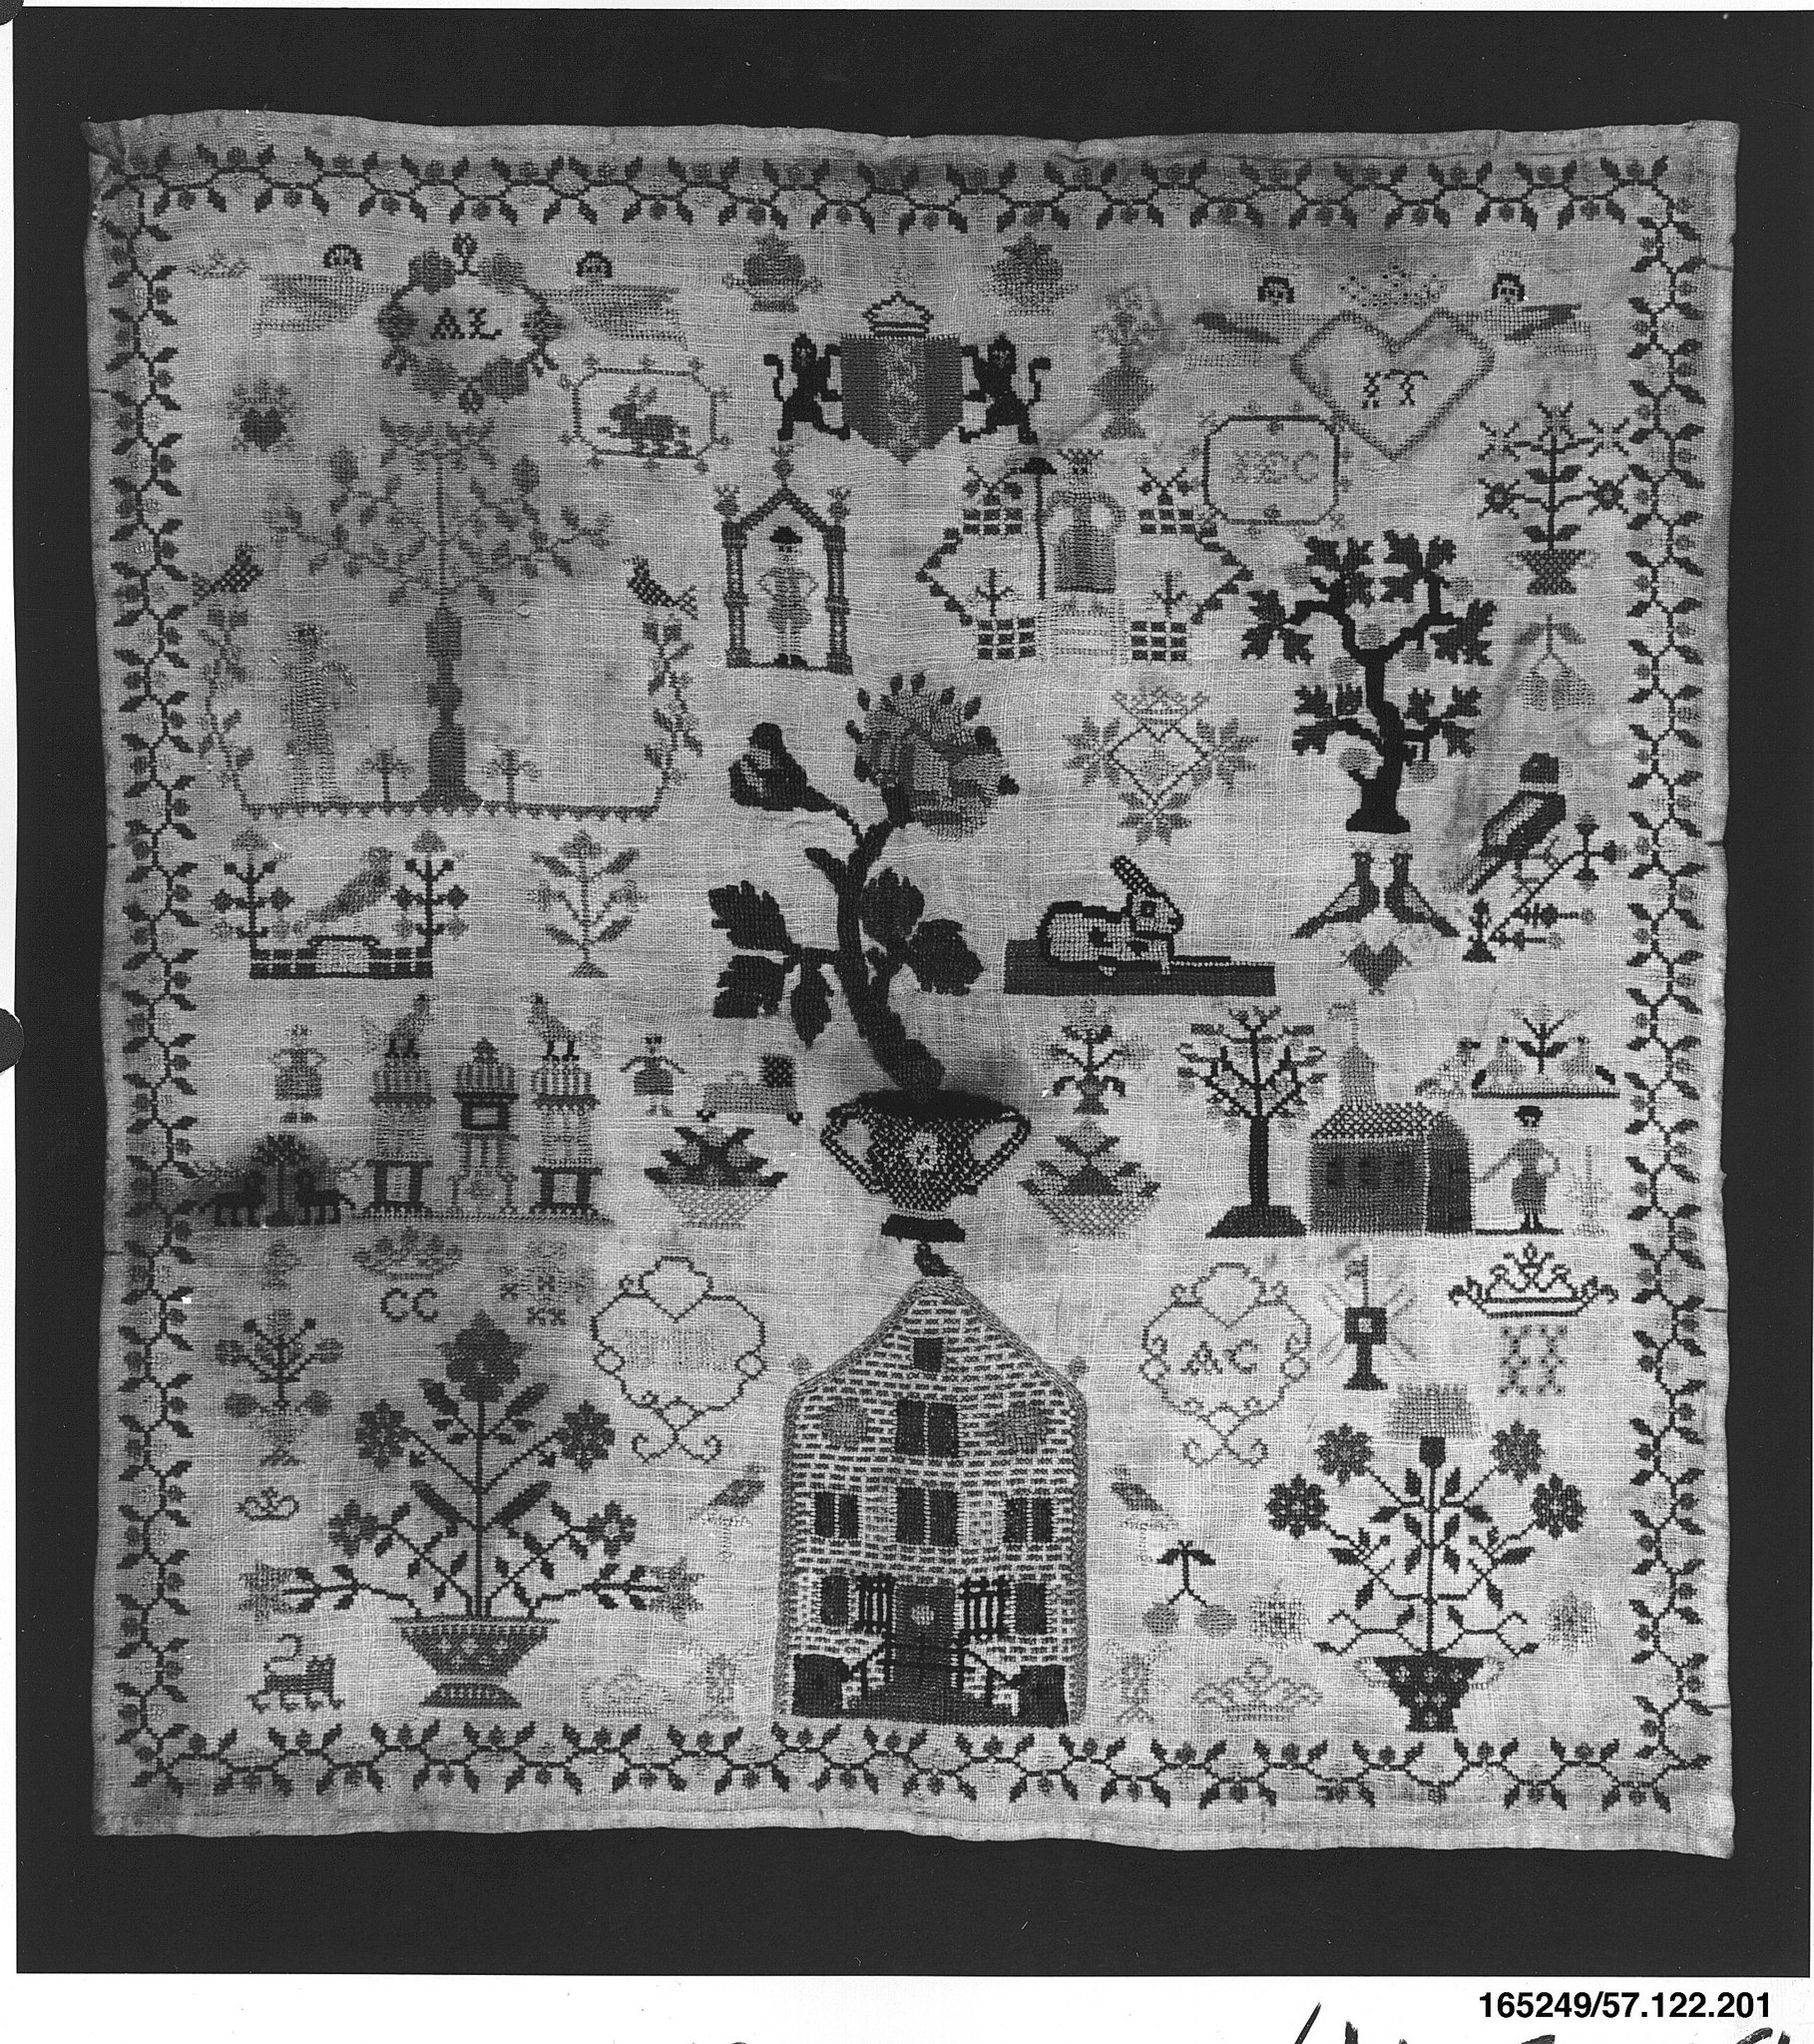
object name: sampler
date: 1701-1800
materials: cotton, silk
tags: houses,rabbits,flowers,insignia